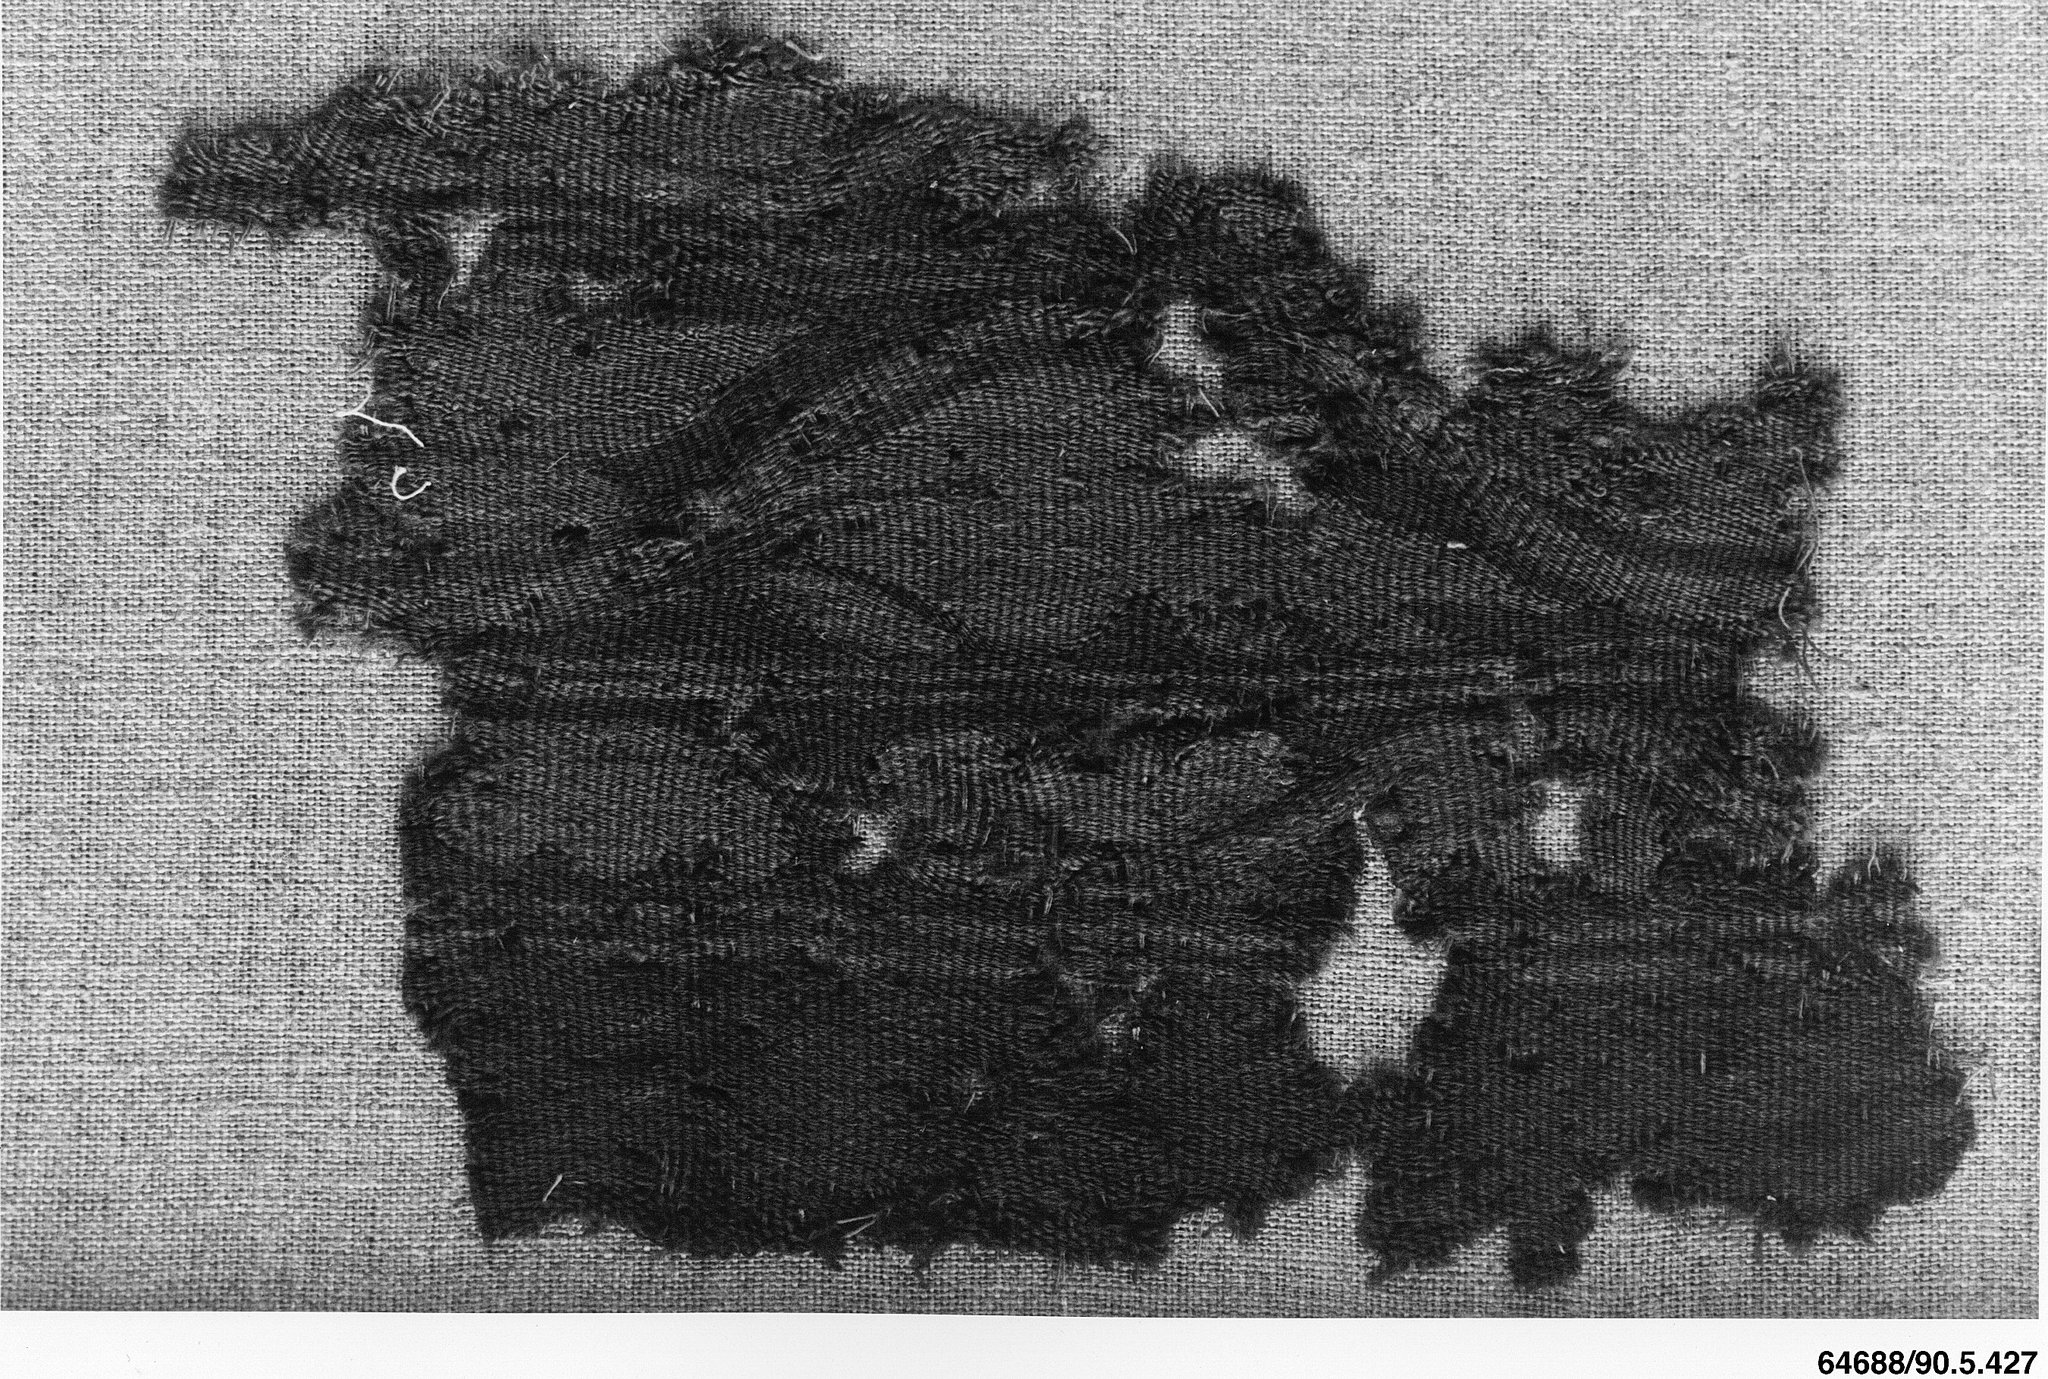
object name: textile fragment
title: Fragment of a Sleeve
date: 301-400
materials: linen, wool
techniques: weave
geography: egypt